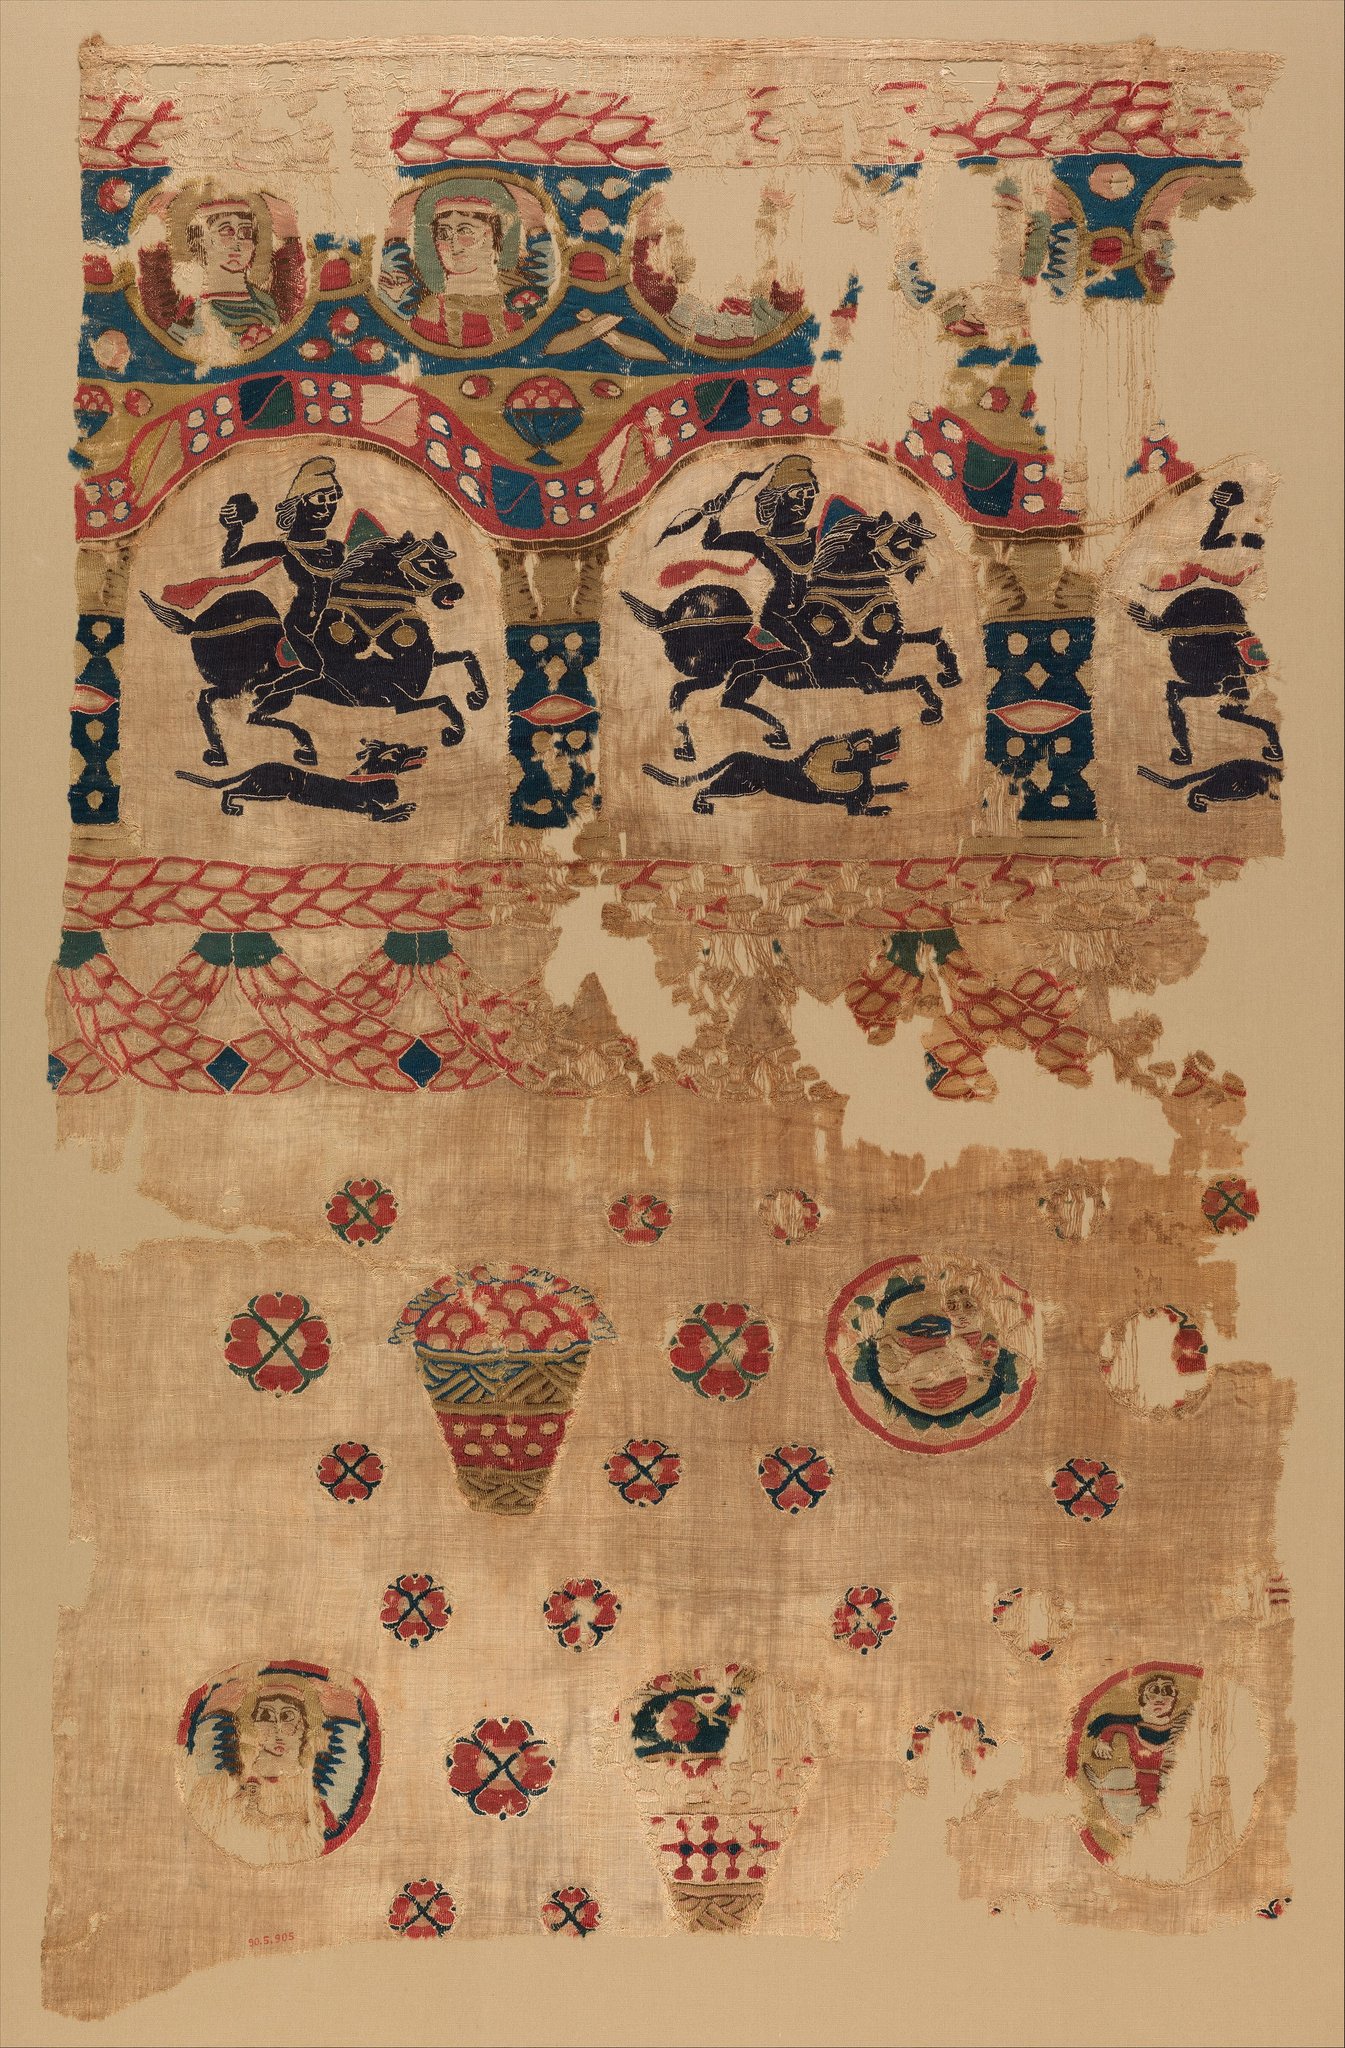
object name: textile fragment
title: Fragment from a Coptic Hanging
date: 401-500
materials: linen, wool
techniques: weave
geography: egypt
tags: horses